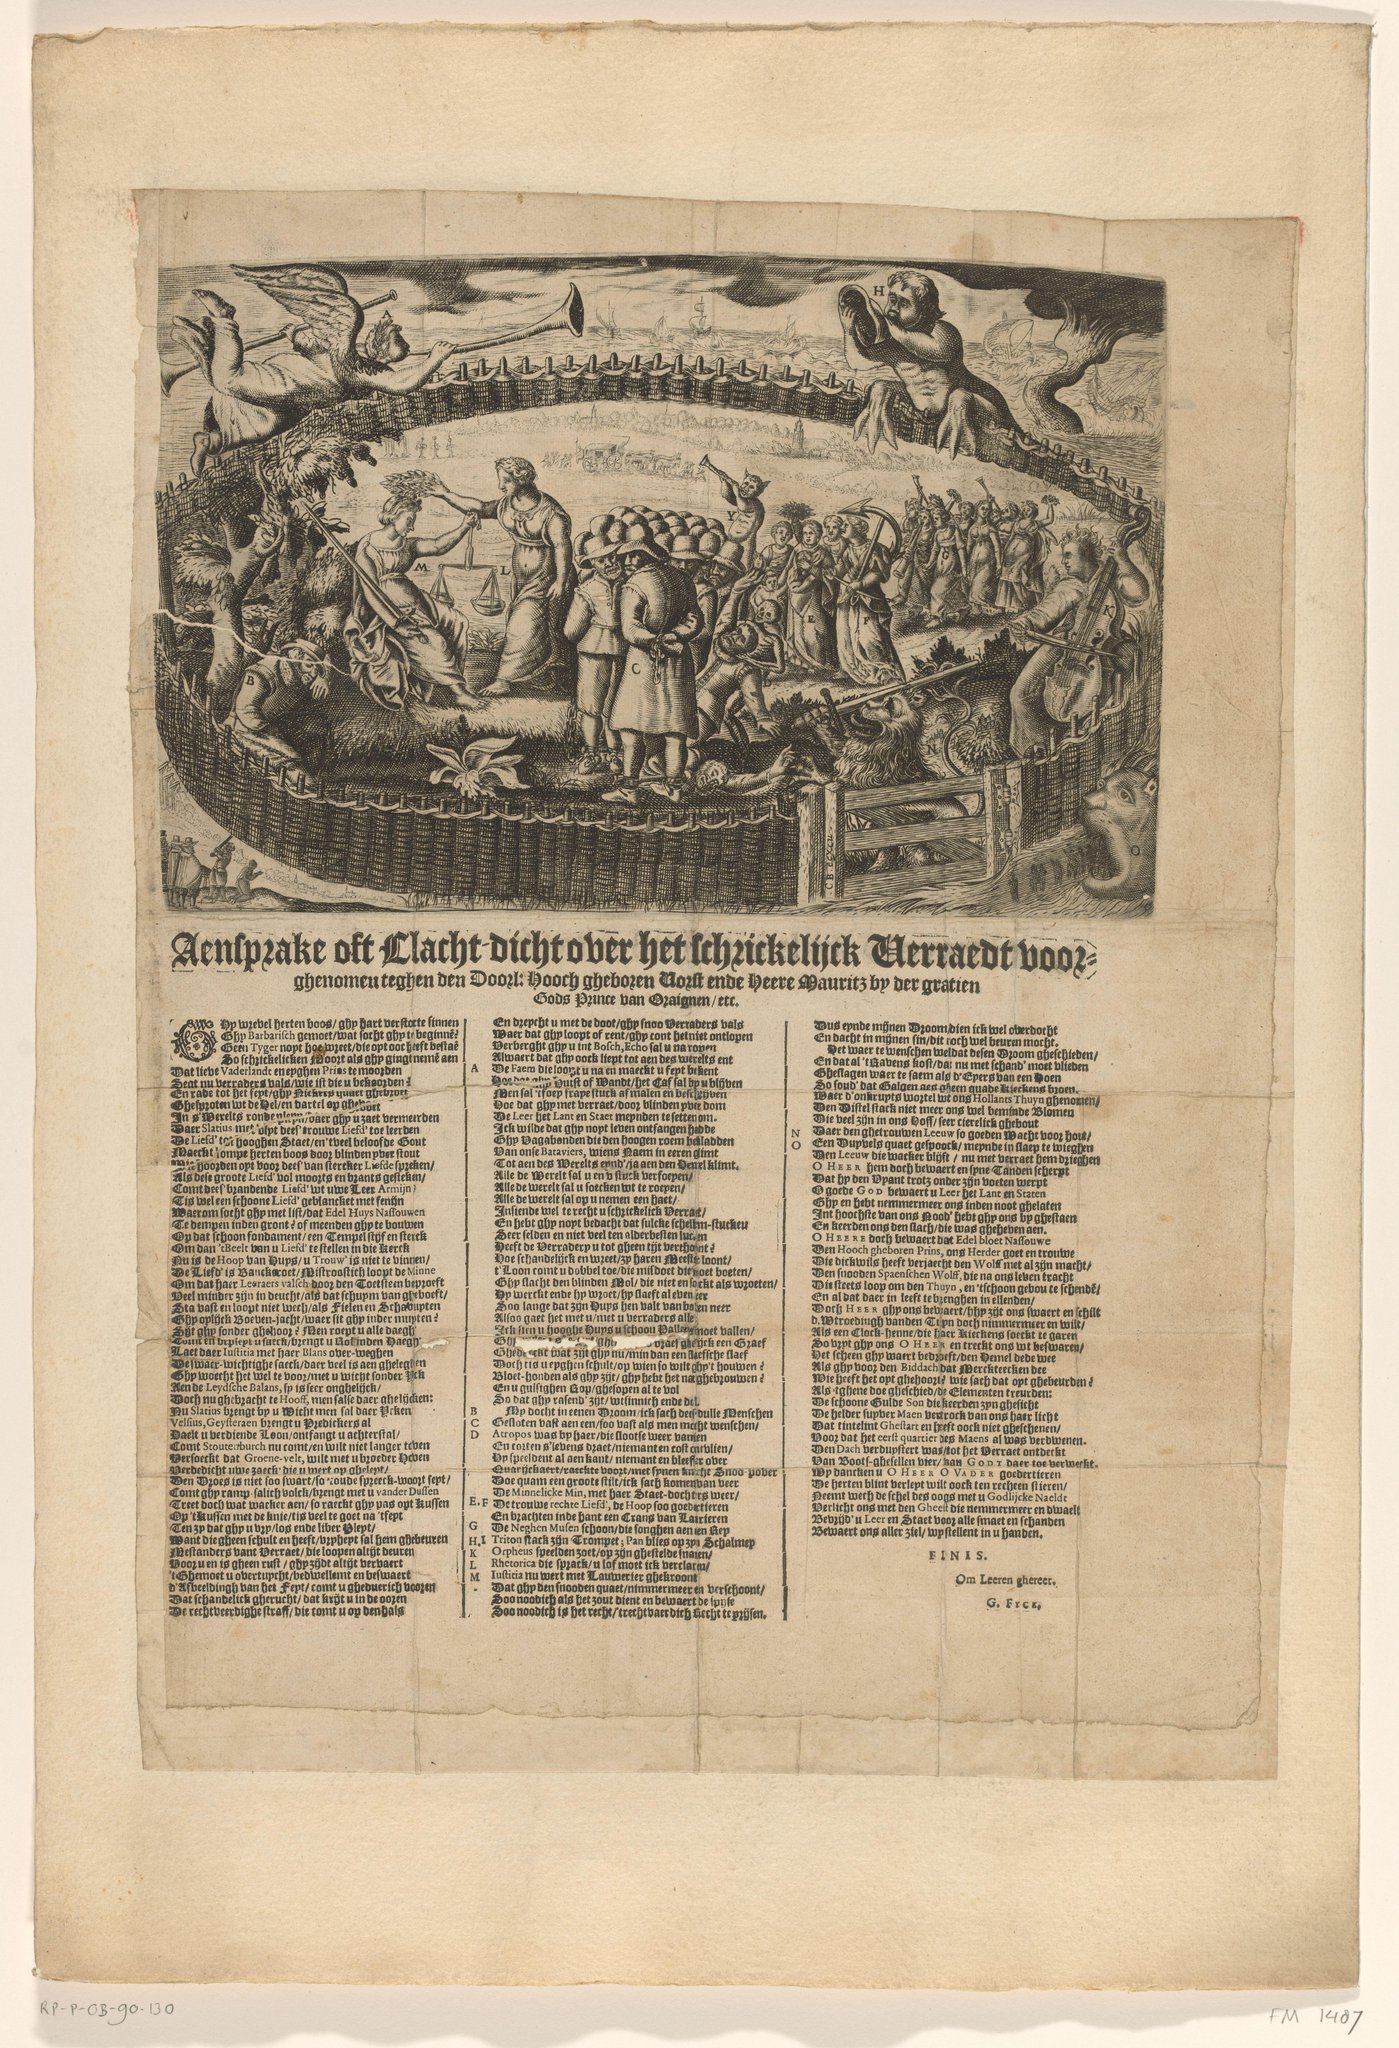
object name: propagandaprent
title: Aensprake oft Clacht-dicht over het schrickelijck Verraedt voorghenomen teghen (...) Mauritz by der gratien Gods Prince van Oraignen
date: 1623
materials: paper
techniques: engraving, letterpress printing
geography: amsterdam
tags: maurice (prince of orange), (revolutionary) plot, conspiracy, non-aggressive, friendly or neutral activities and relationships of orpheus, fenced or walled garden; 'hortus conclusus', fame; 'fama', 'fama buona', 'fama chiara' (ripa)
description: Allegorie op de gevangenneming van de samenzweerders tegen Maurits, 1623. In de Hollandse Tui staan de gevangengenomen geketende samenzweerders. Links kroont Rhetorica de Rechtvaardigheid, rechts een optocht van Liefde en Hoop gevolgd door negen muzen. Orpheus speelt op een cello, de Hollandse Leeuw wacht bij de poort. In de lucht de Faam, uit het water komend blaast Triton op zijn hoorn. Onder de plaat gedrukt 3 kolommen tekst in het Nederlands.